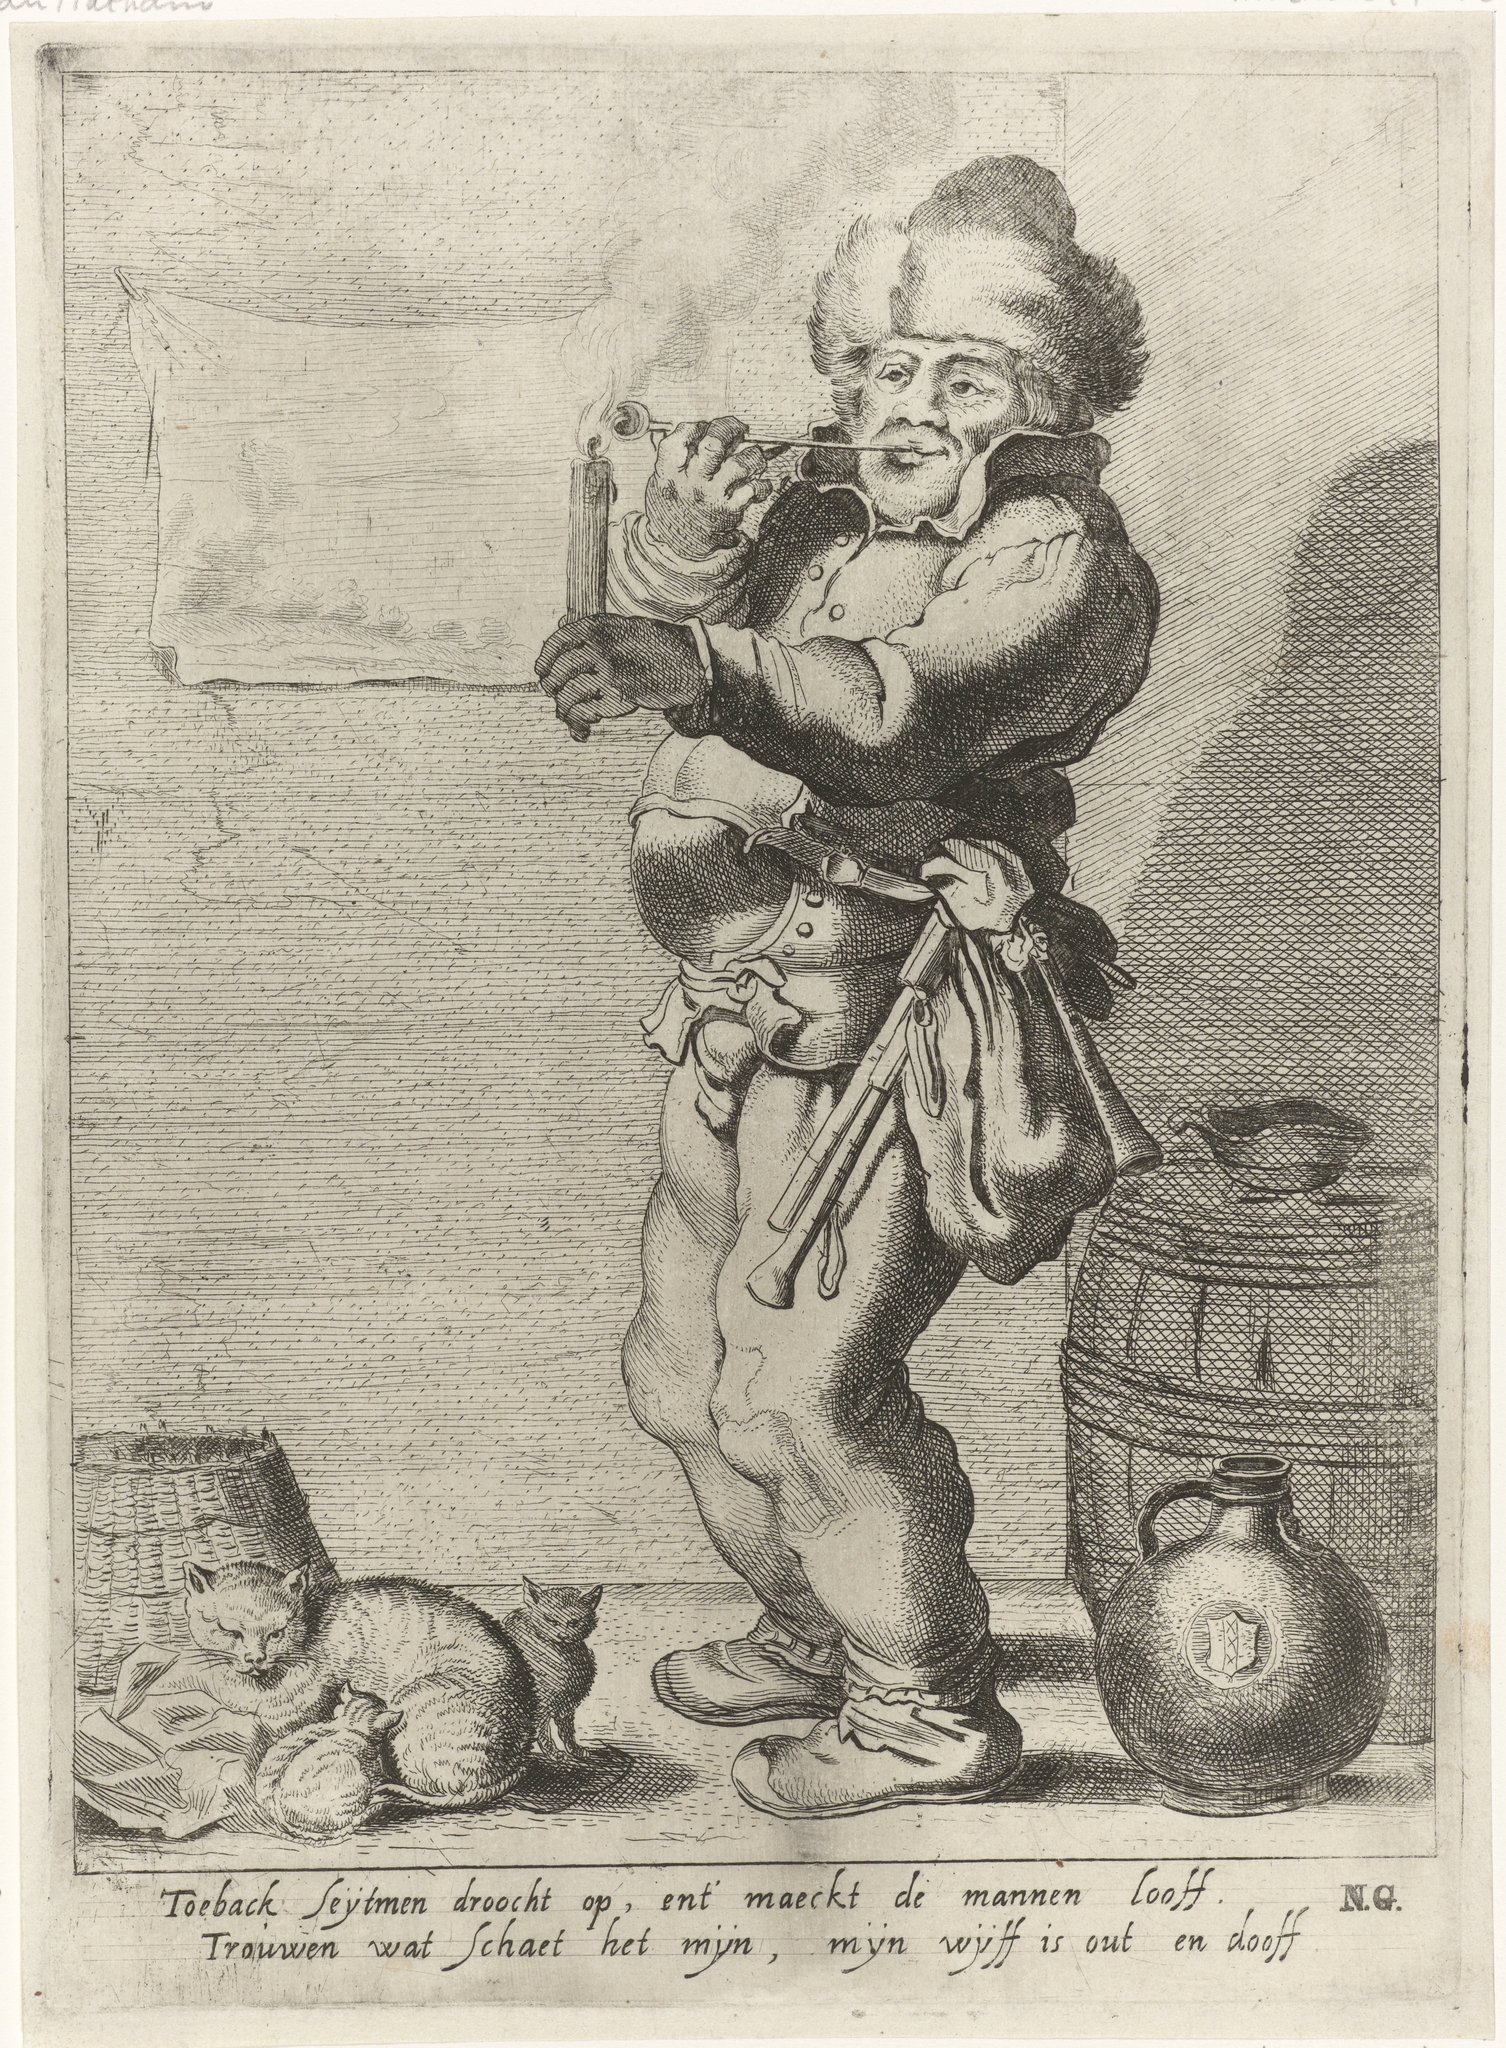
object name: print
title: Rokende boer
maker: jan matham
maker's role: print maker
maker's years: 1600-1648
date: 1628-1648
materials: paper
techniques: engraving, etching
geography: haarlem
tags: cat, pipe ~ tobacco, farmers, candle, container of ceramics: jar, jug, pot, vase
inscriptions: collector's mark: Lugt 2228, collector's mark: Lugt 1967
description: Een boer, staande in een interieur, steekt zijn pijp aan met een kaars. Op zijn heup hangt een doedelzak. Naast hem staan een kruik en een ton en voor zijn voeten ligt een kat met jongen. Op de wand achter hem hangt een afbeelding.